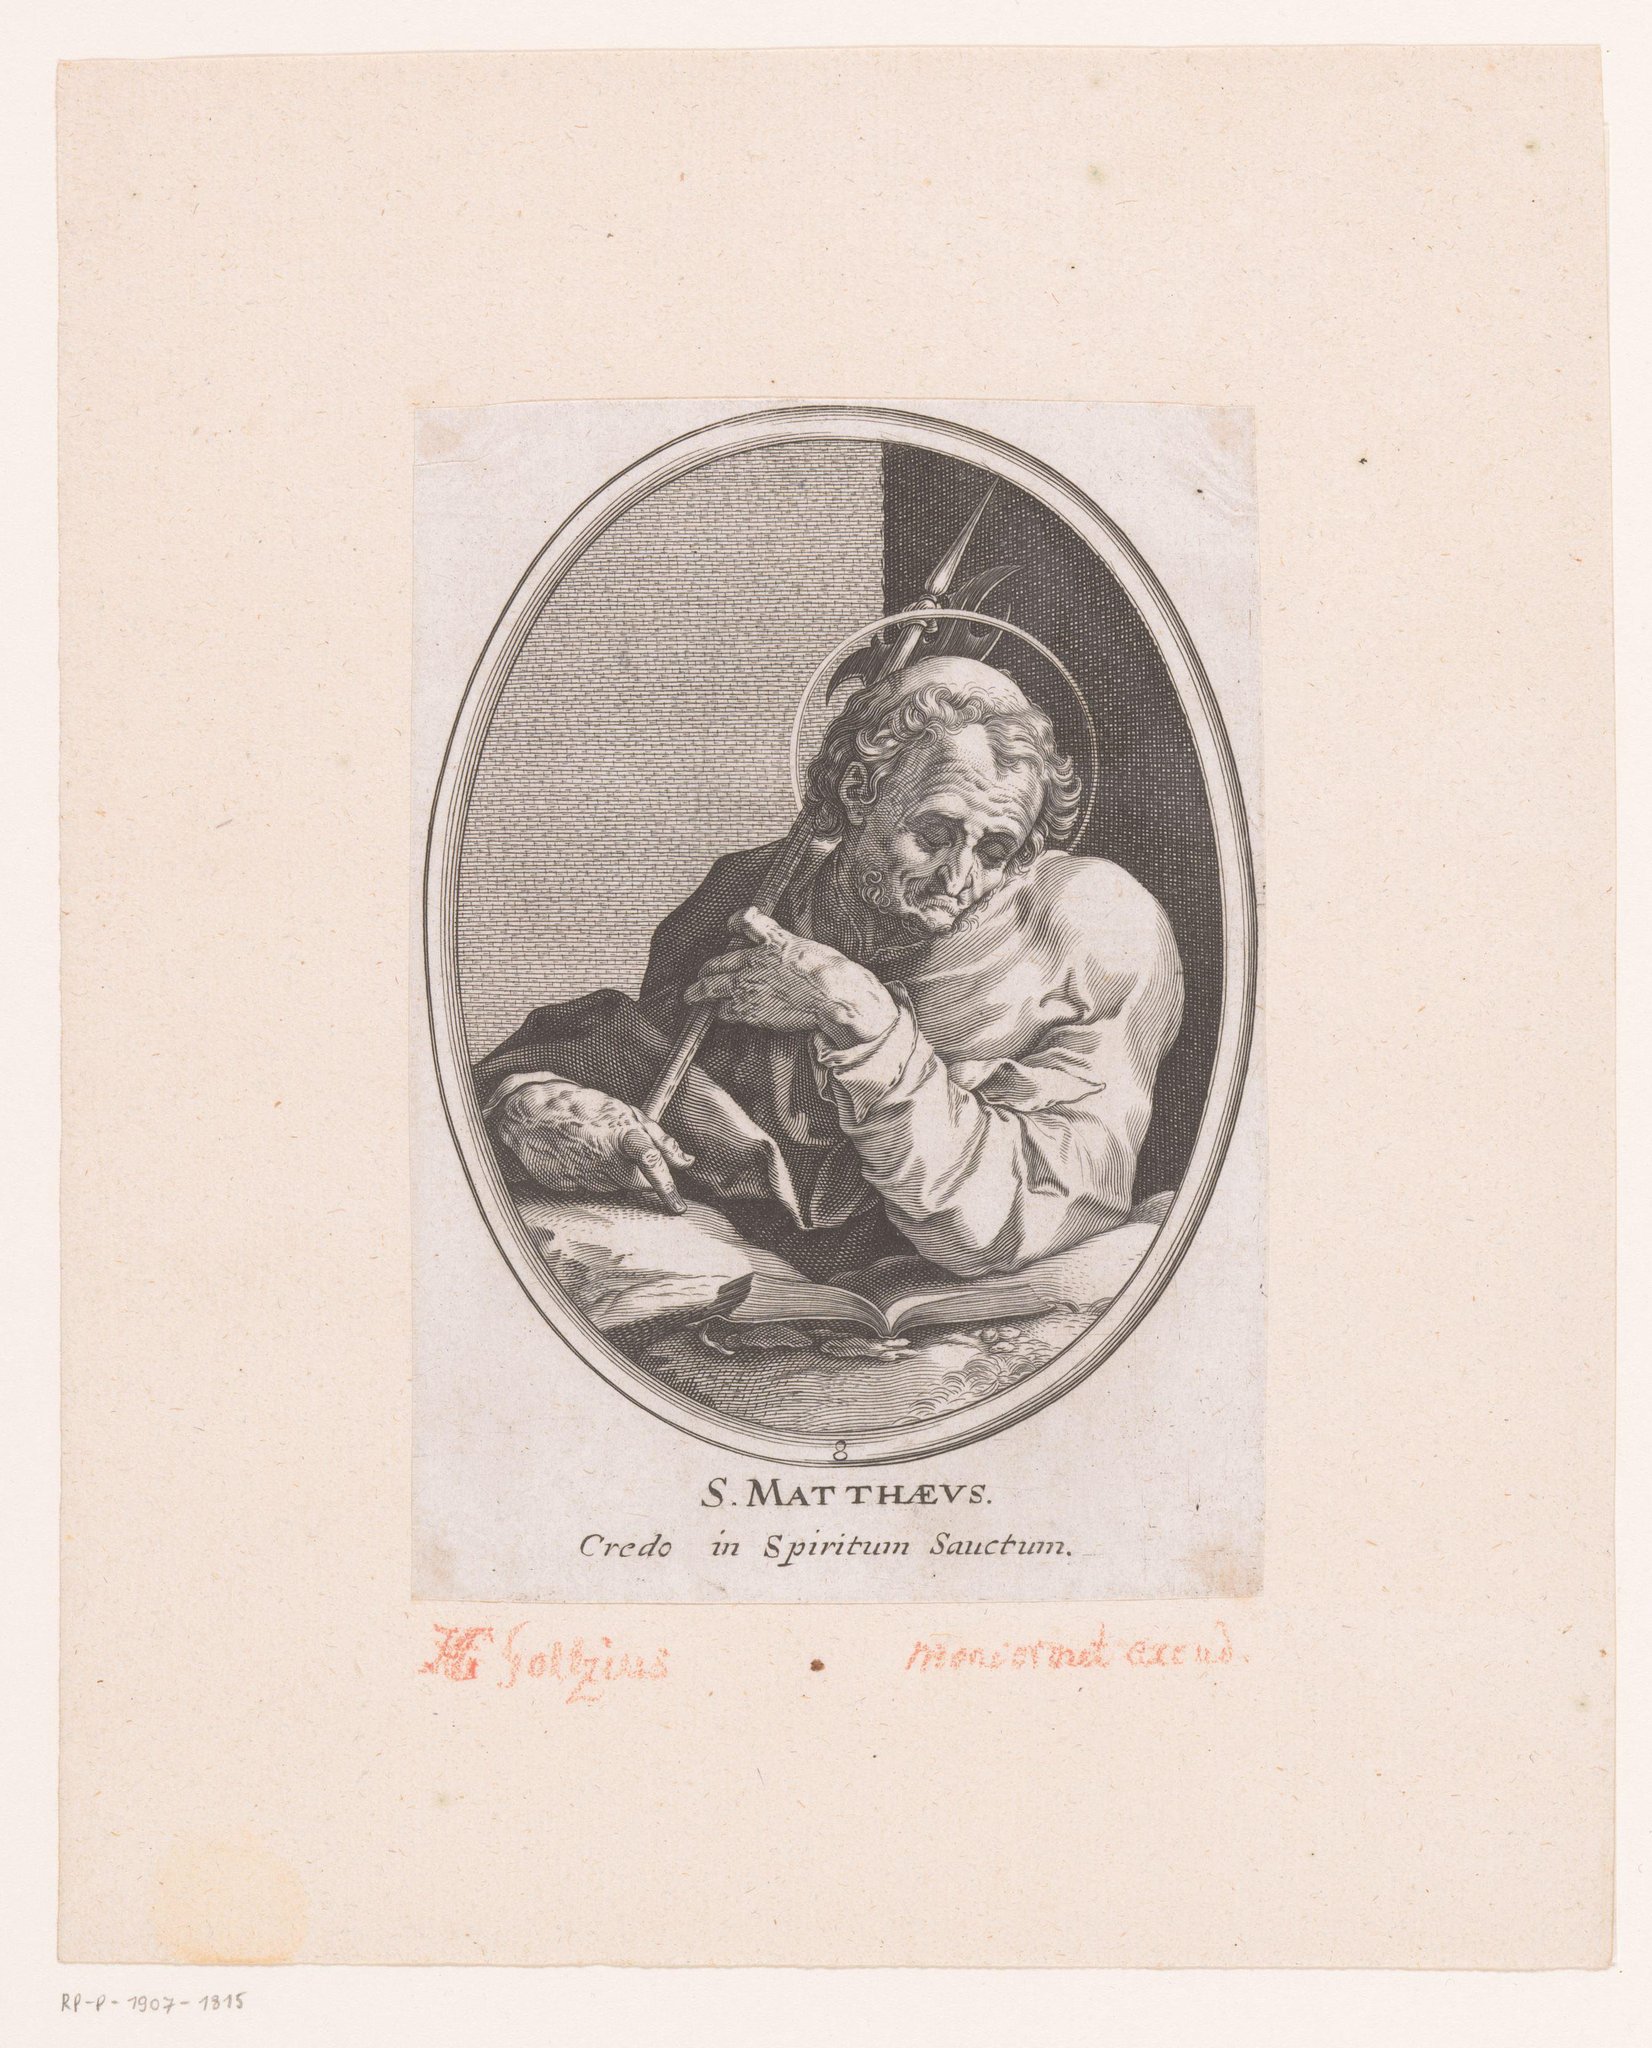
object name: print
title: Portret van H. Matteus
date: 1610-1668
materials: paper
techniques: engraving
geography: paris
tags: the apostle and evangelist matthew (mattheus); possible attributes: angel, axe, book, halberd, pen and inkhorn, purse, scroll, square, sword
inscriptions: collector's mark: Lugt 2228